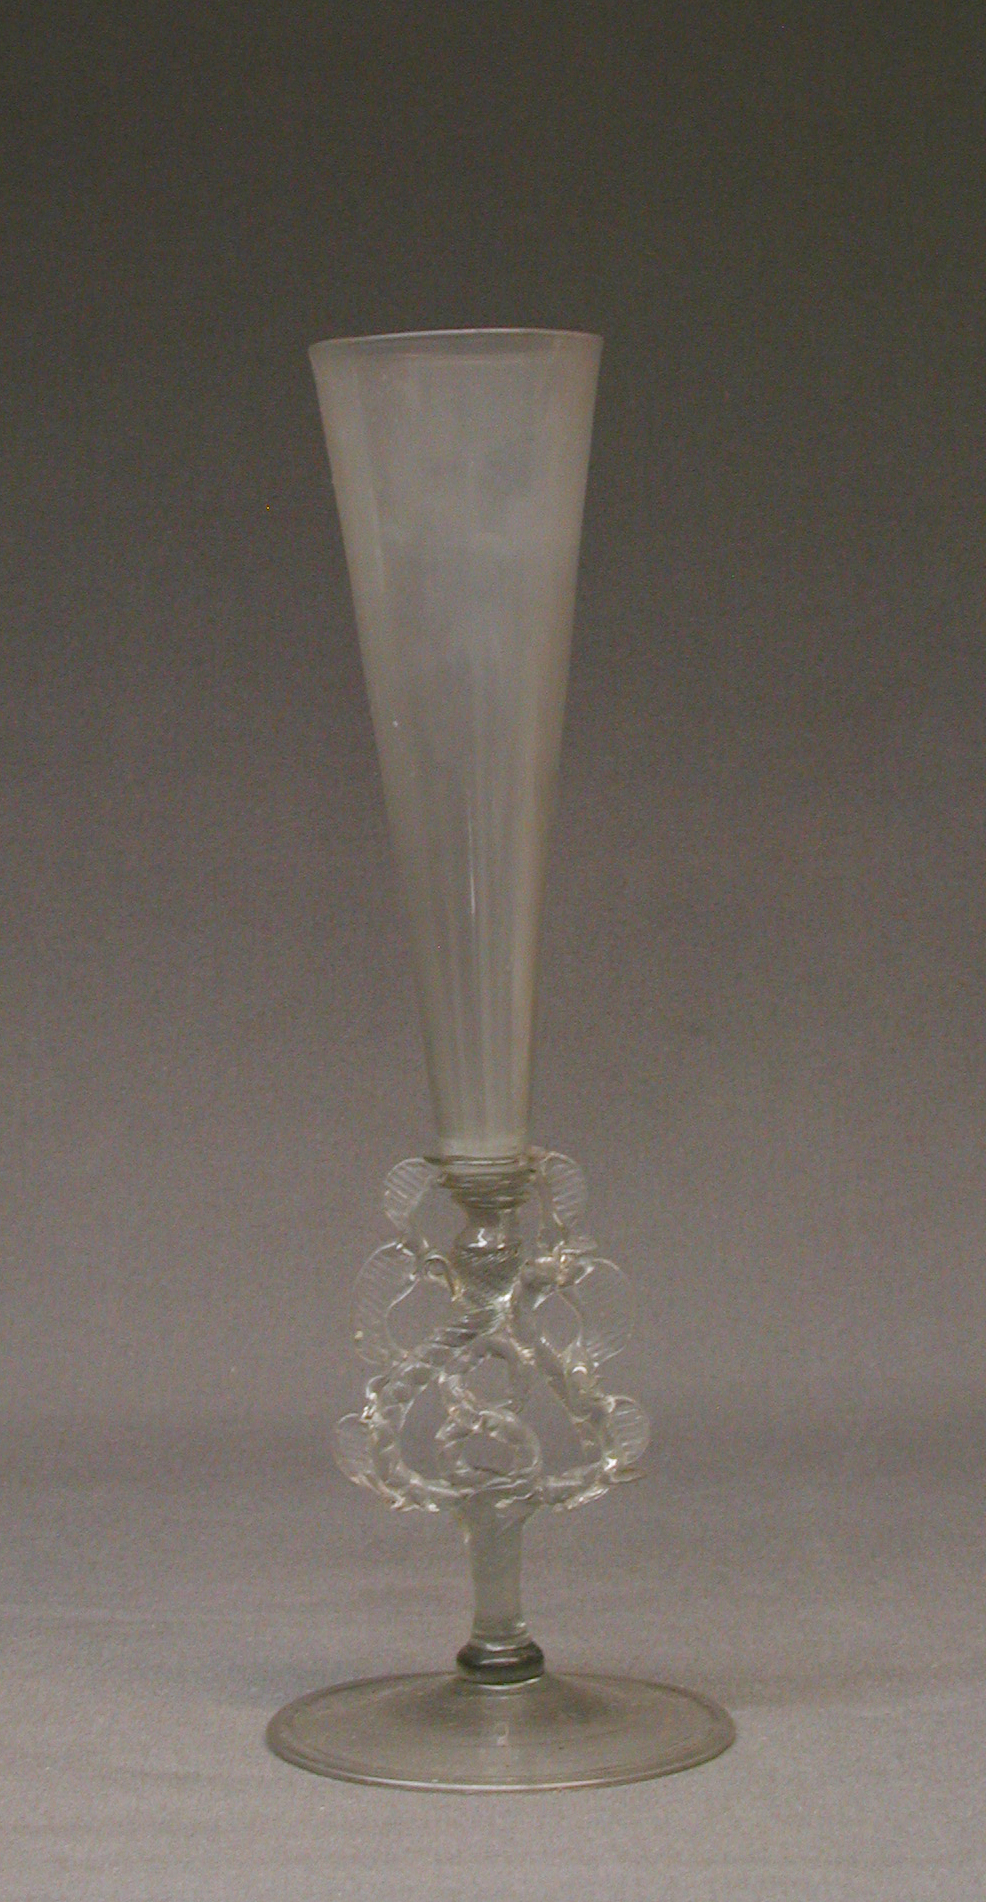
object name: wineglass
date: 1667-1700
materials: glass